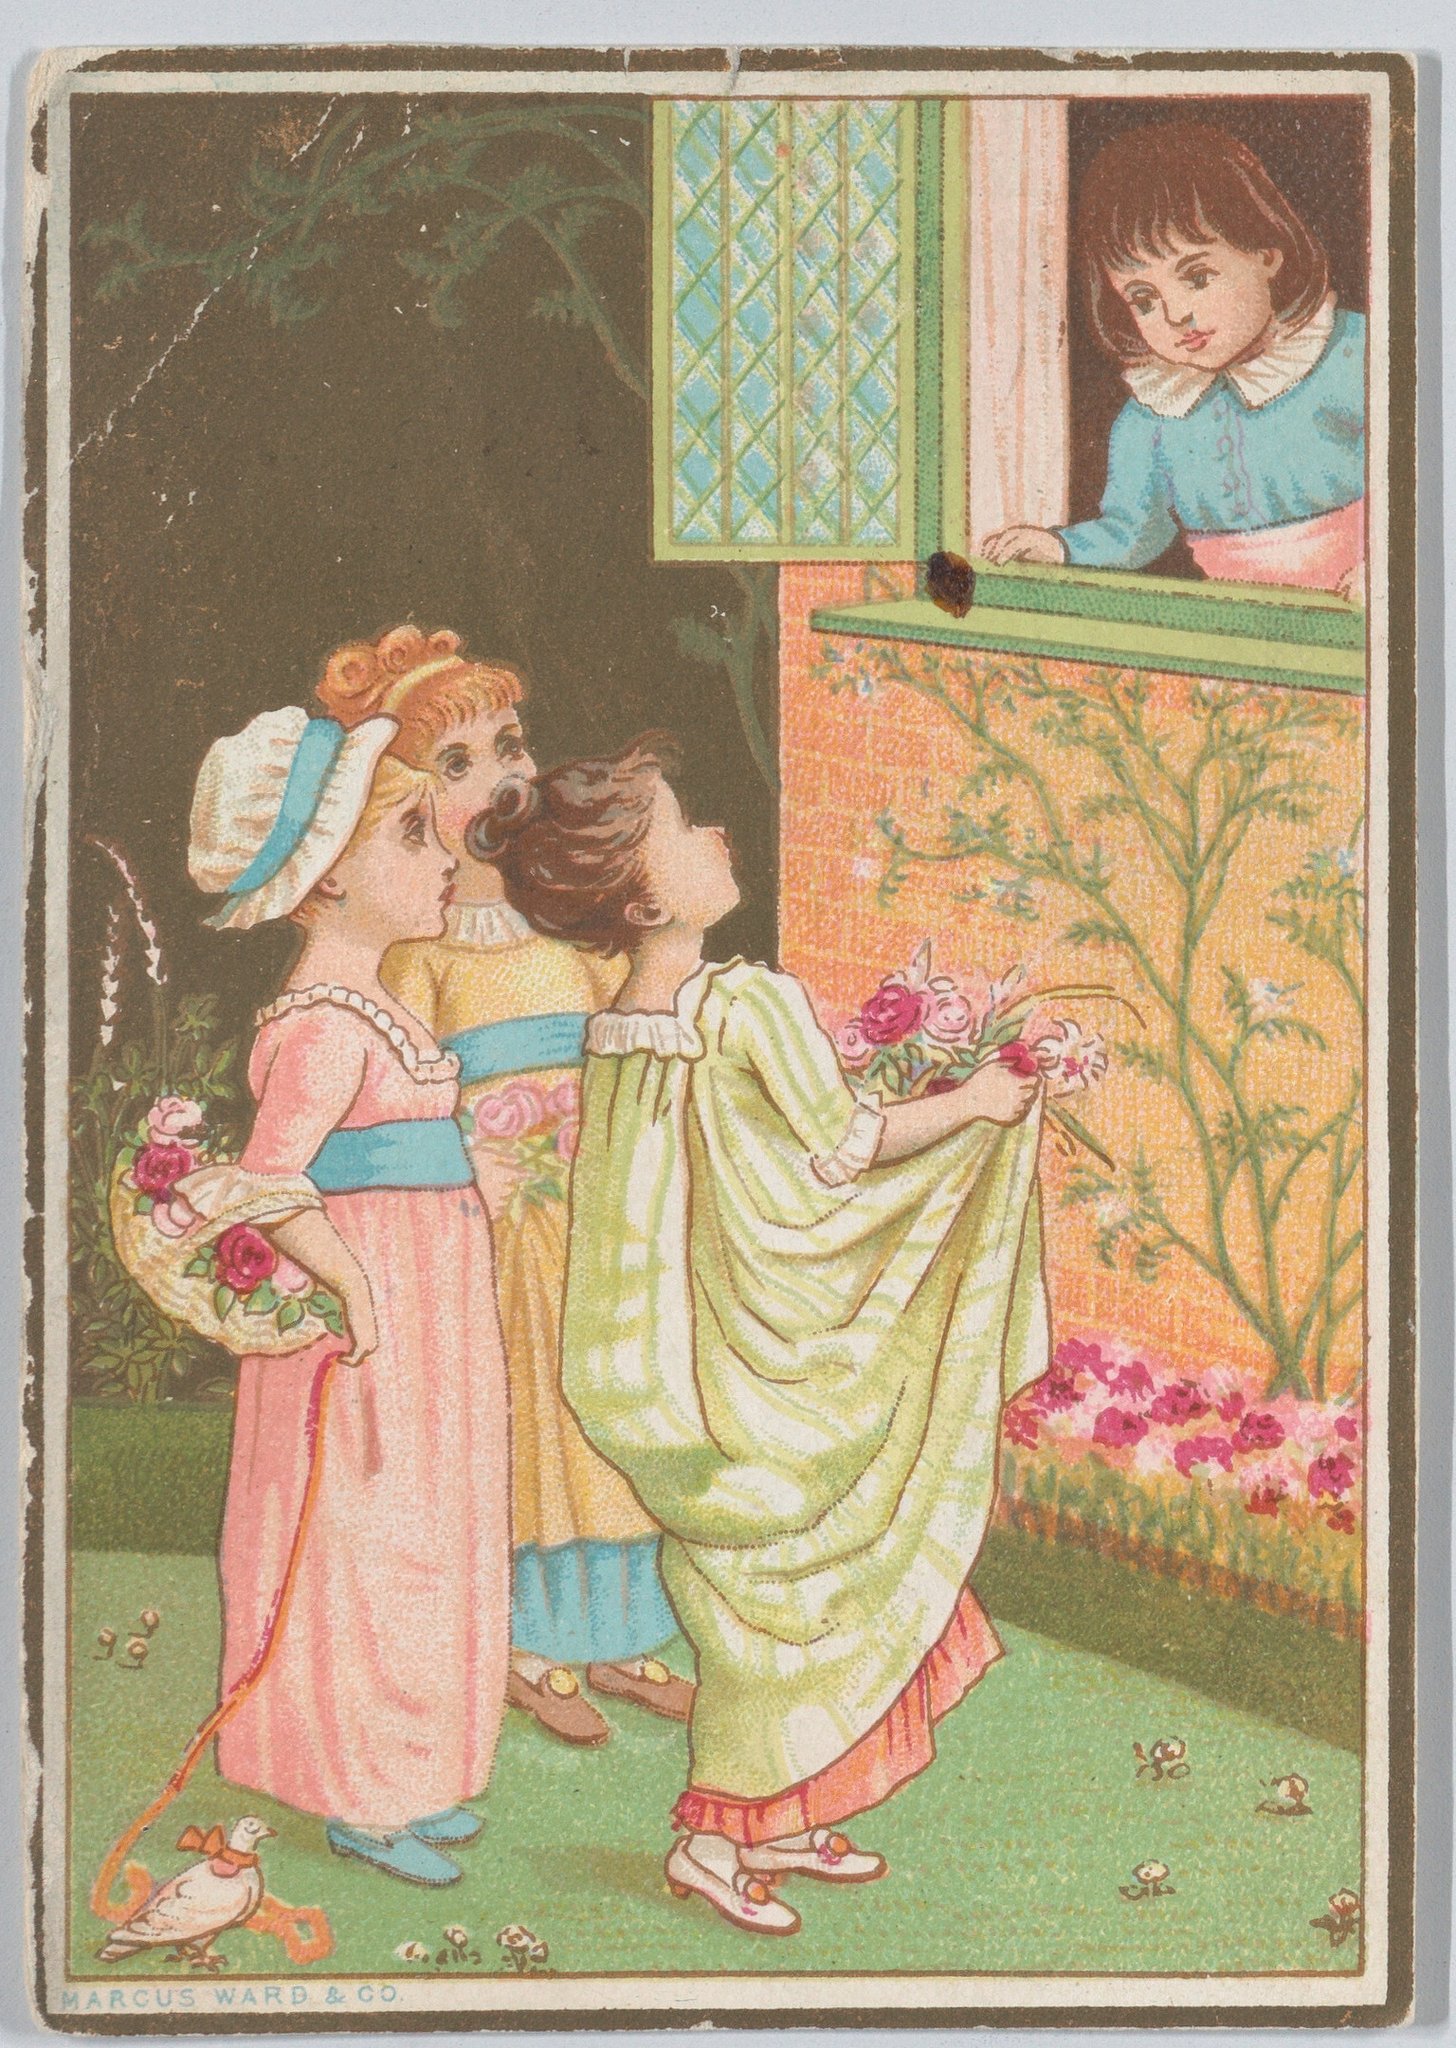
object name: valentine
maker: kate greenaway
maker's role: artist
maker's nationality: british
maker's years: 1846-1901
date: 1883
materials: gold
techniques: chromolithography, gilding, lithograph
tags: boys,girls